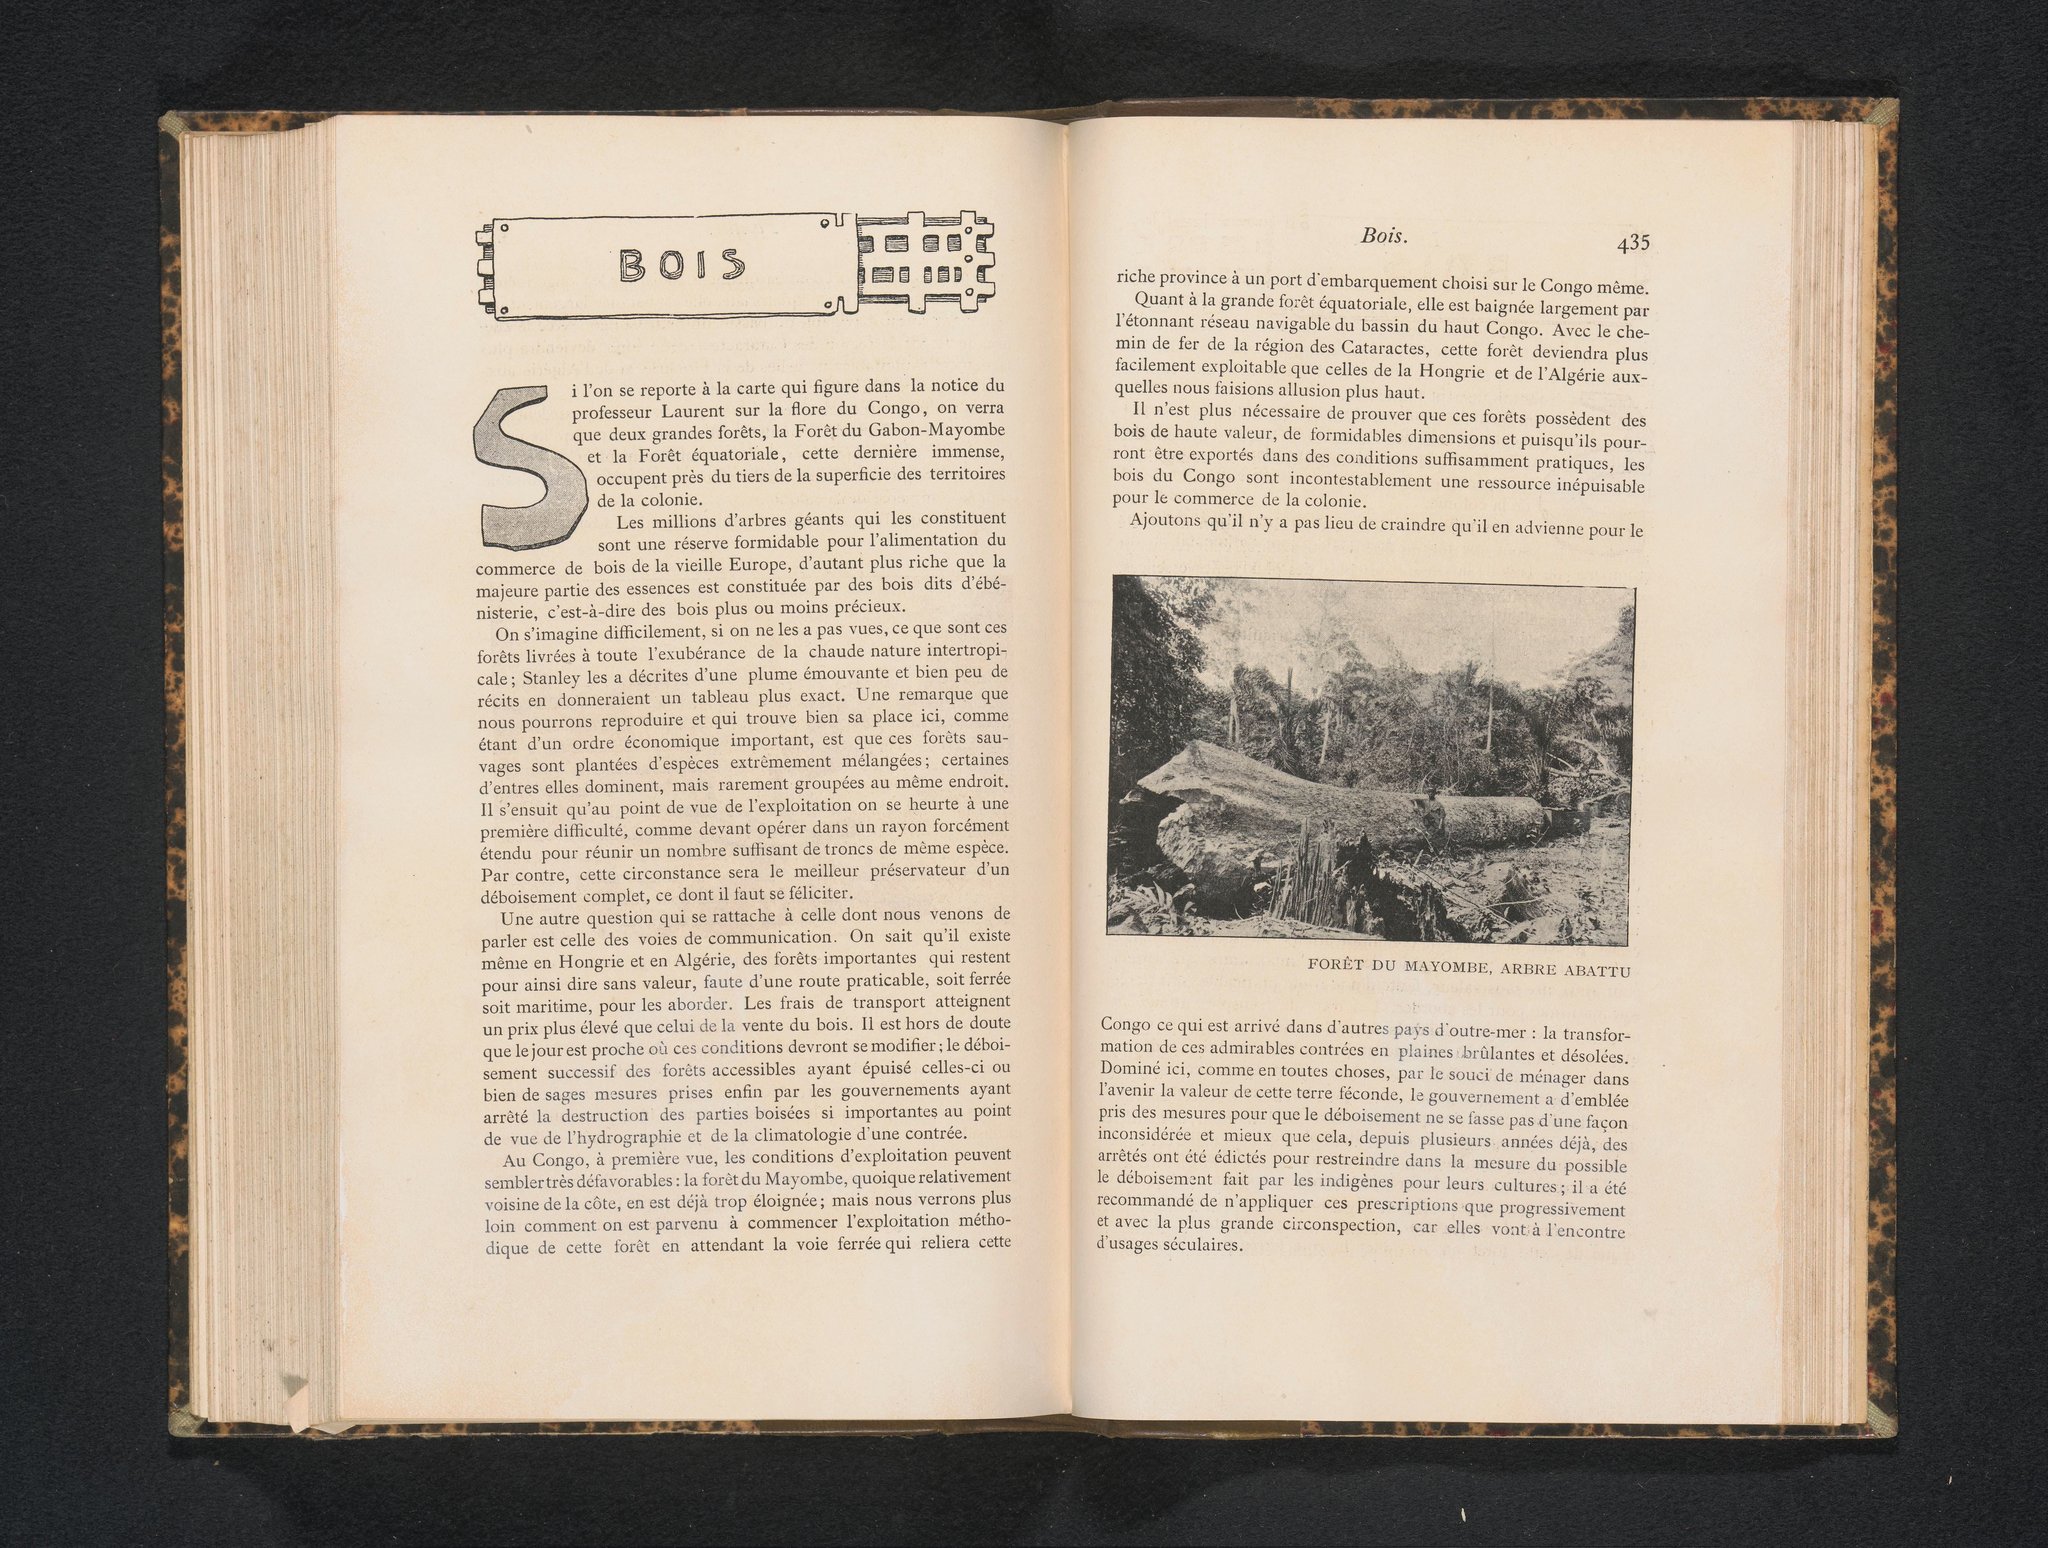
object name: page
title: Forêt du Mayombe, arbre abattu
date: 1887-1892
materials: paper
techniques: autotype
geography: congo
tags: trees, forest, wood